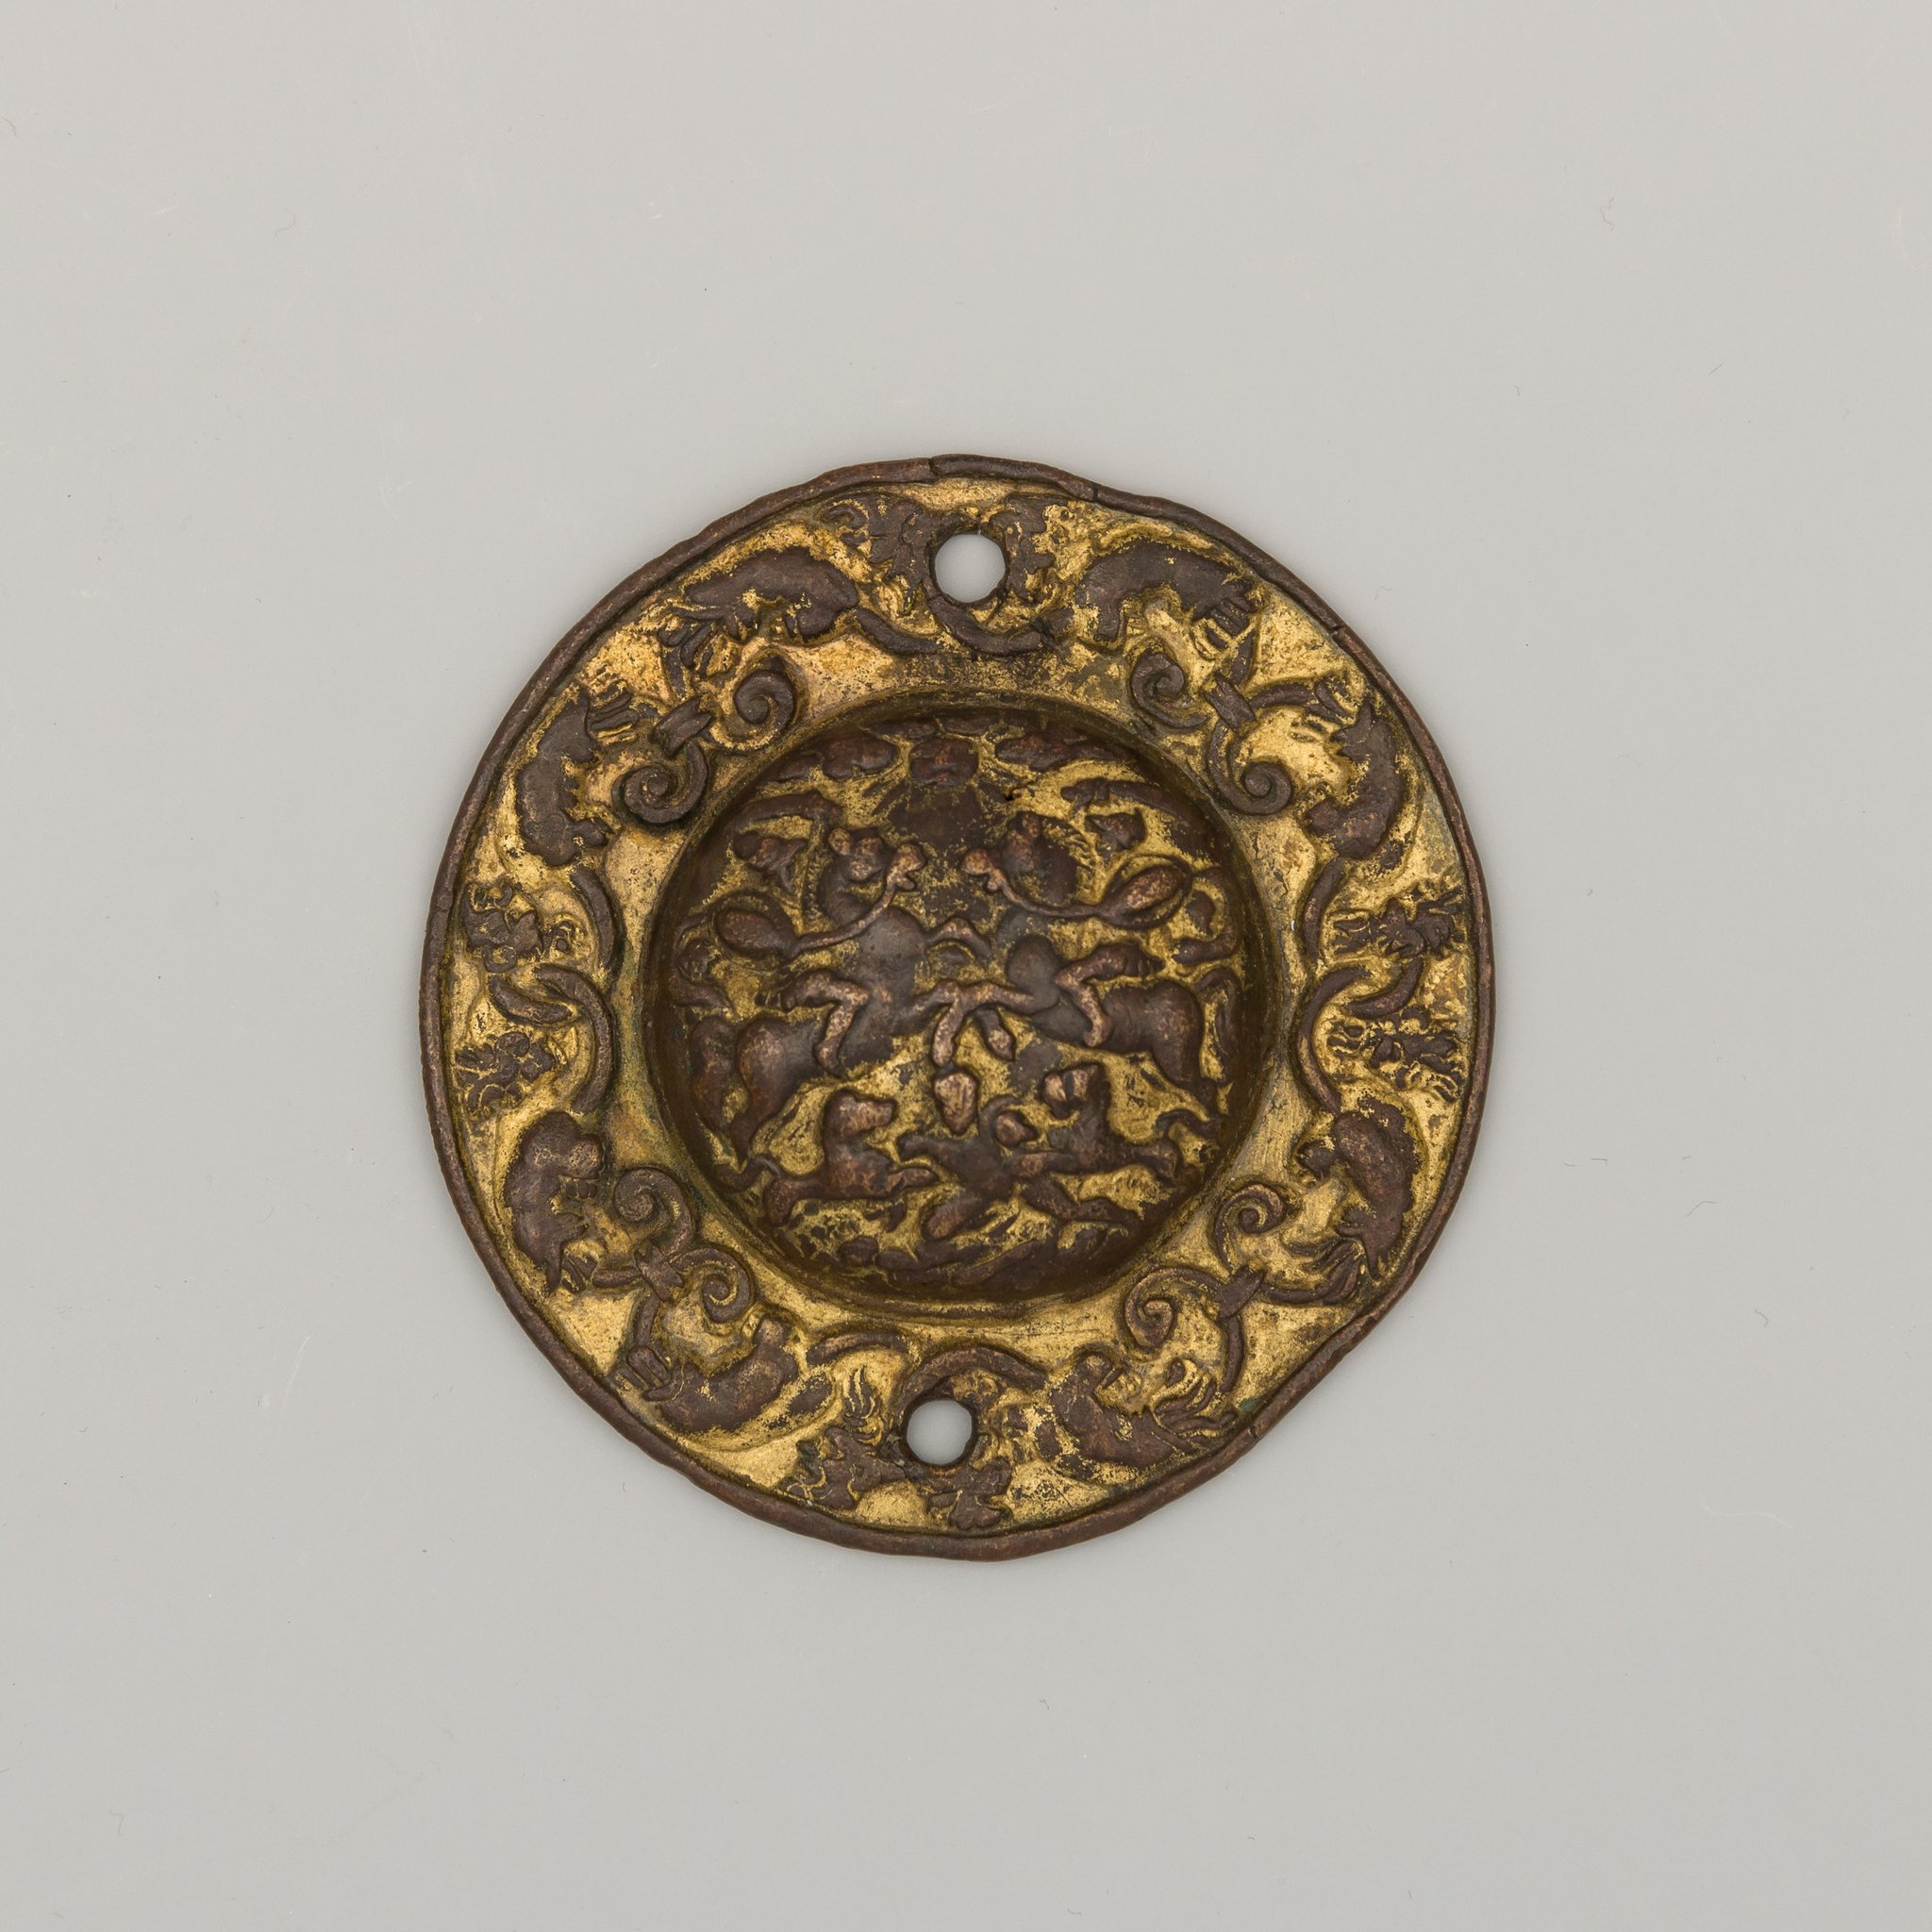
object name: bit bos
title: Bit Boss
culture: german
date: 1567-1700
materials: copper alloy, gold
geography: germany